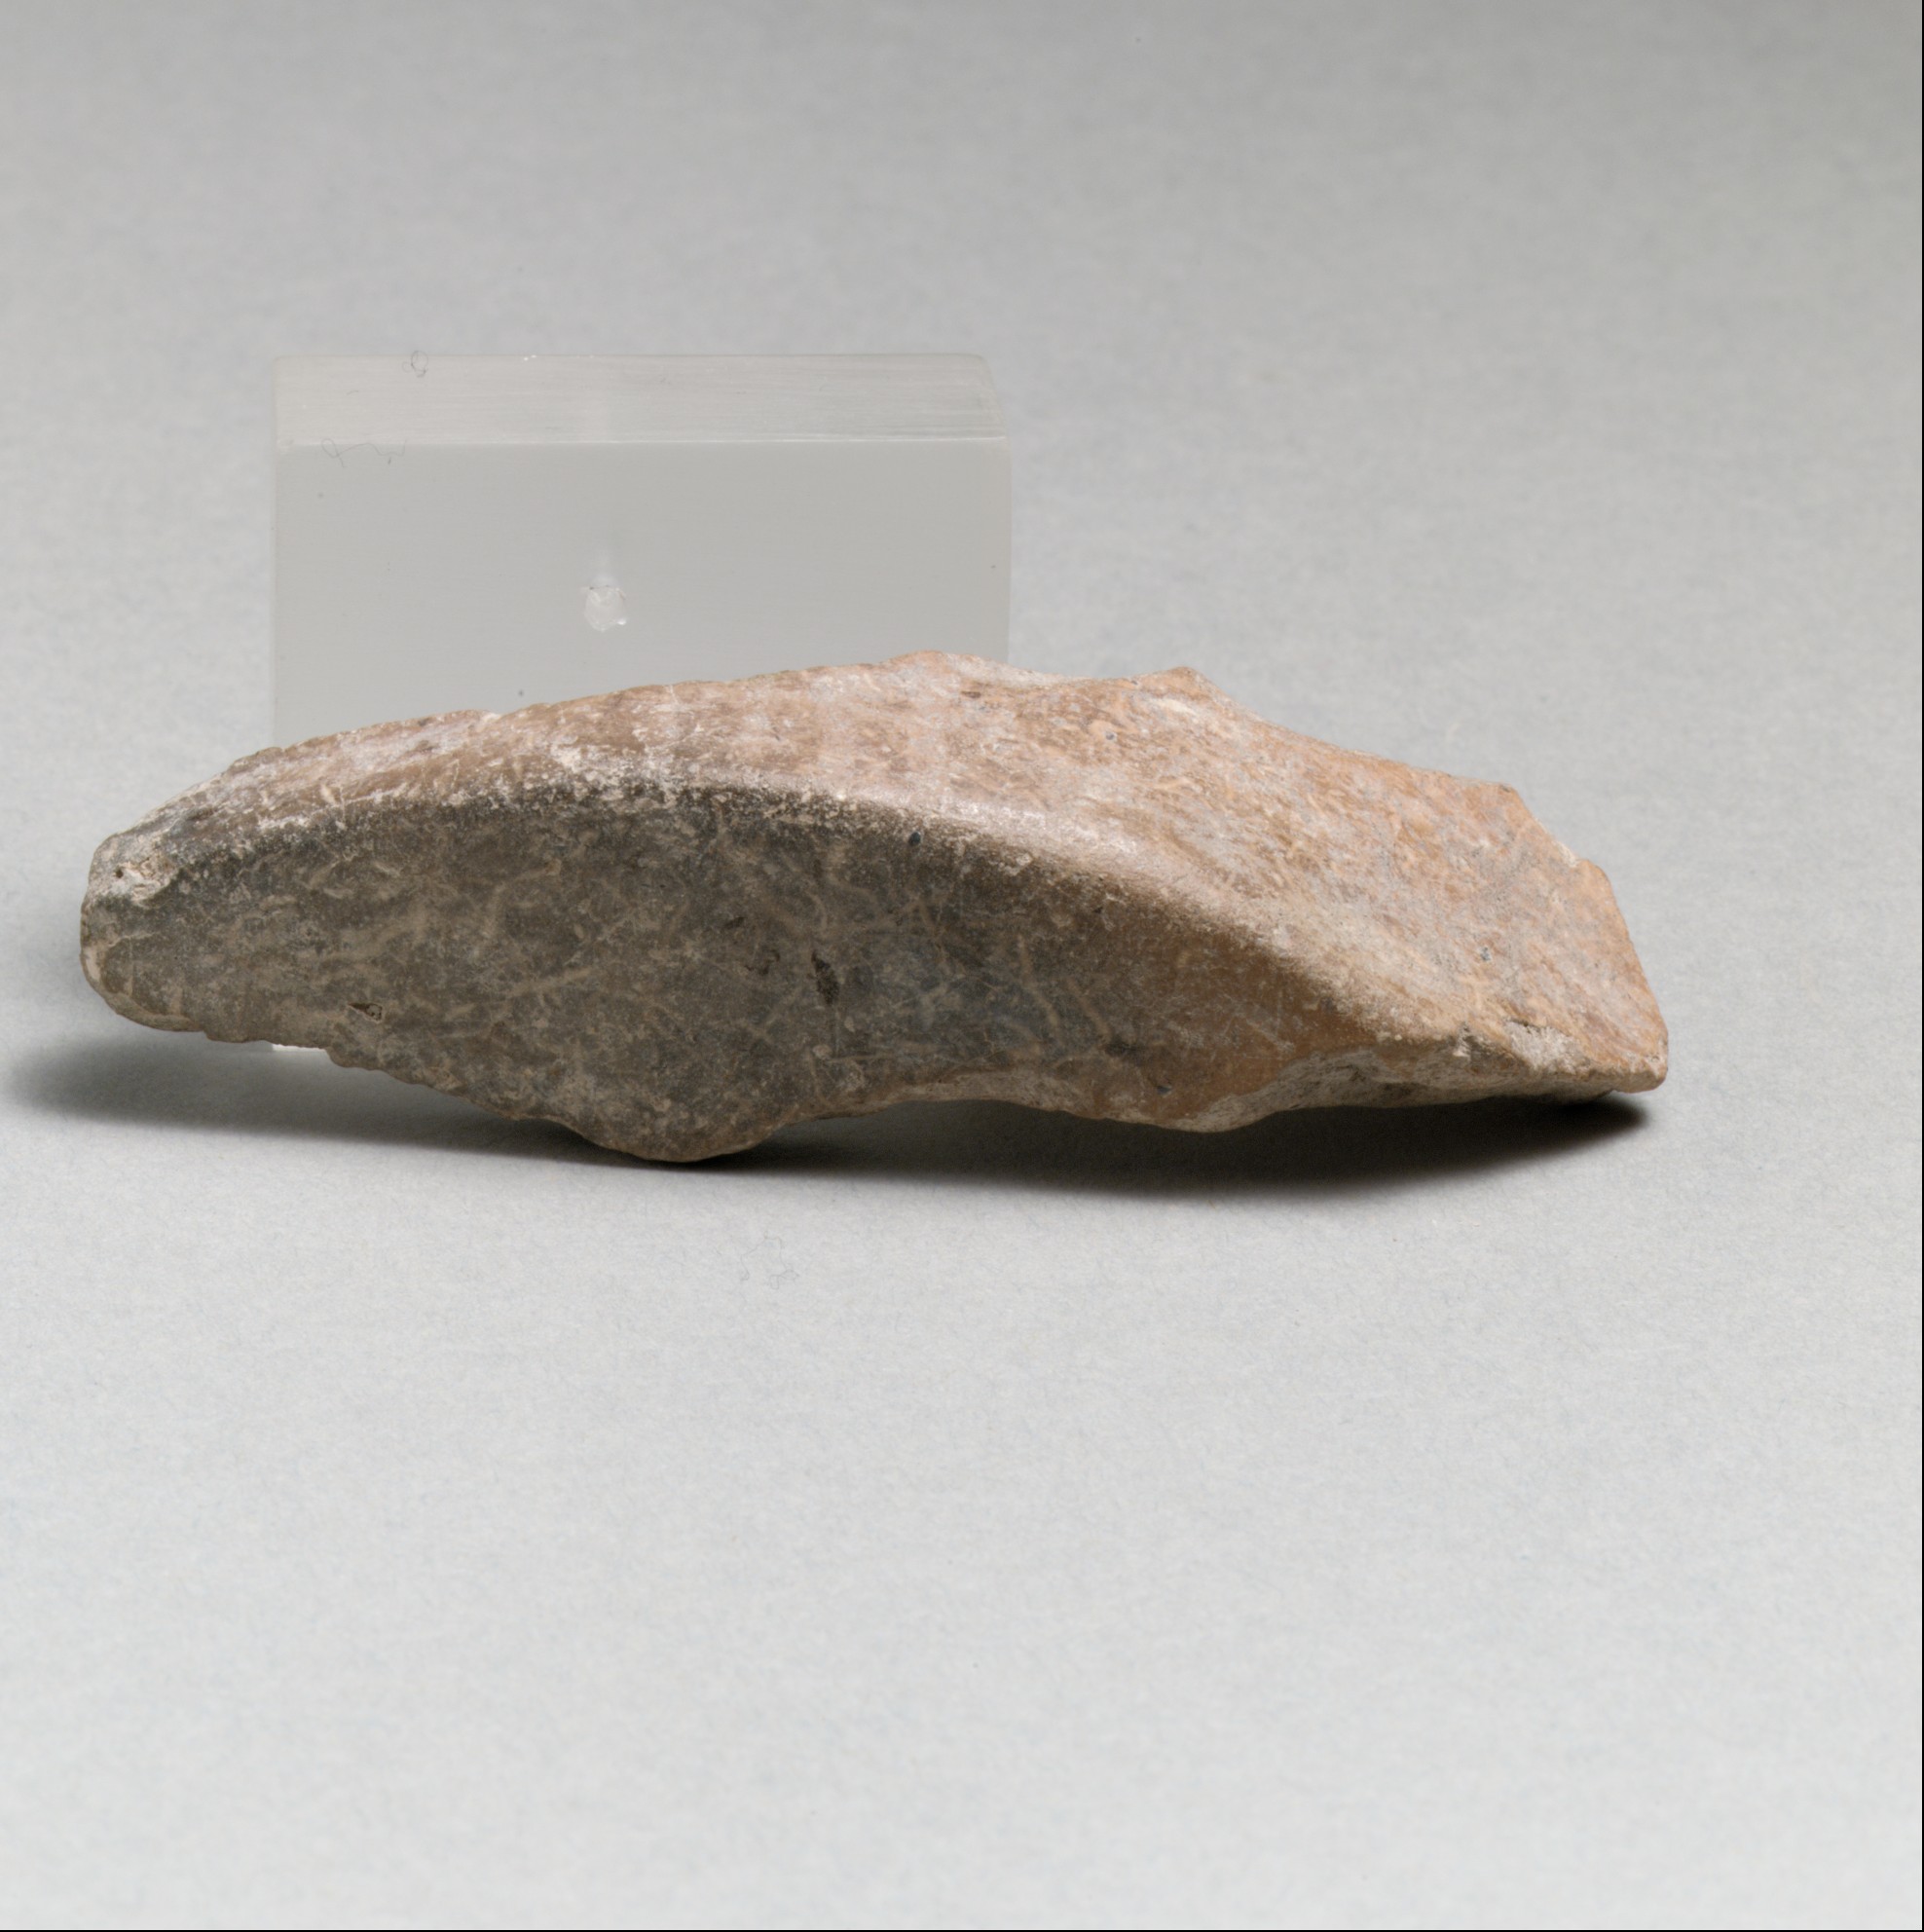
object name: vase fragment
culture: neolithic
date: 6500-5800 BCE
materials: terracotta